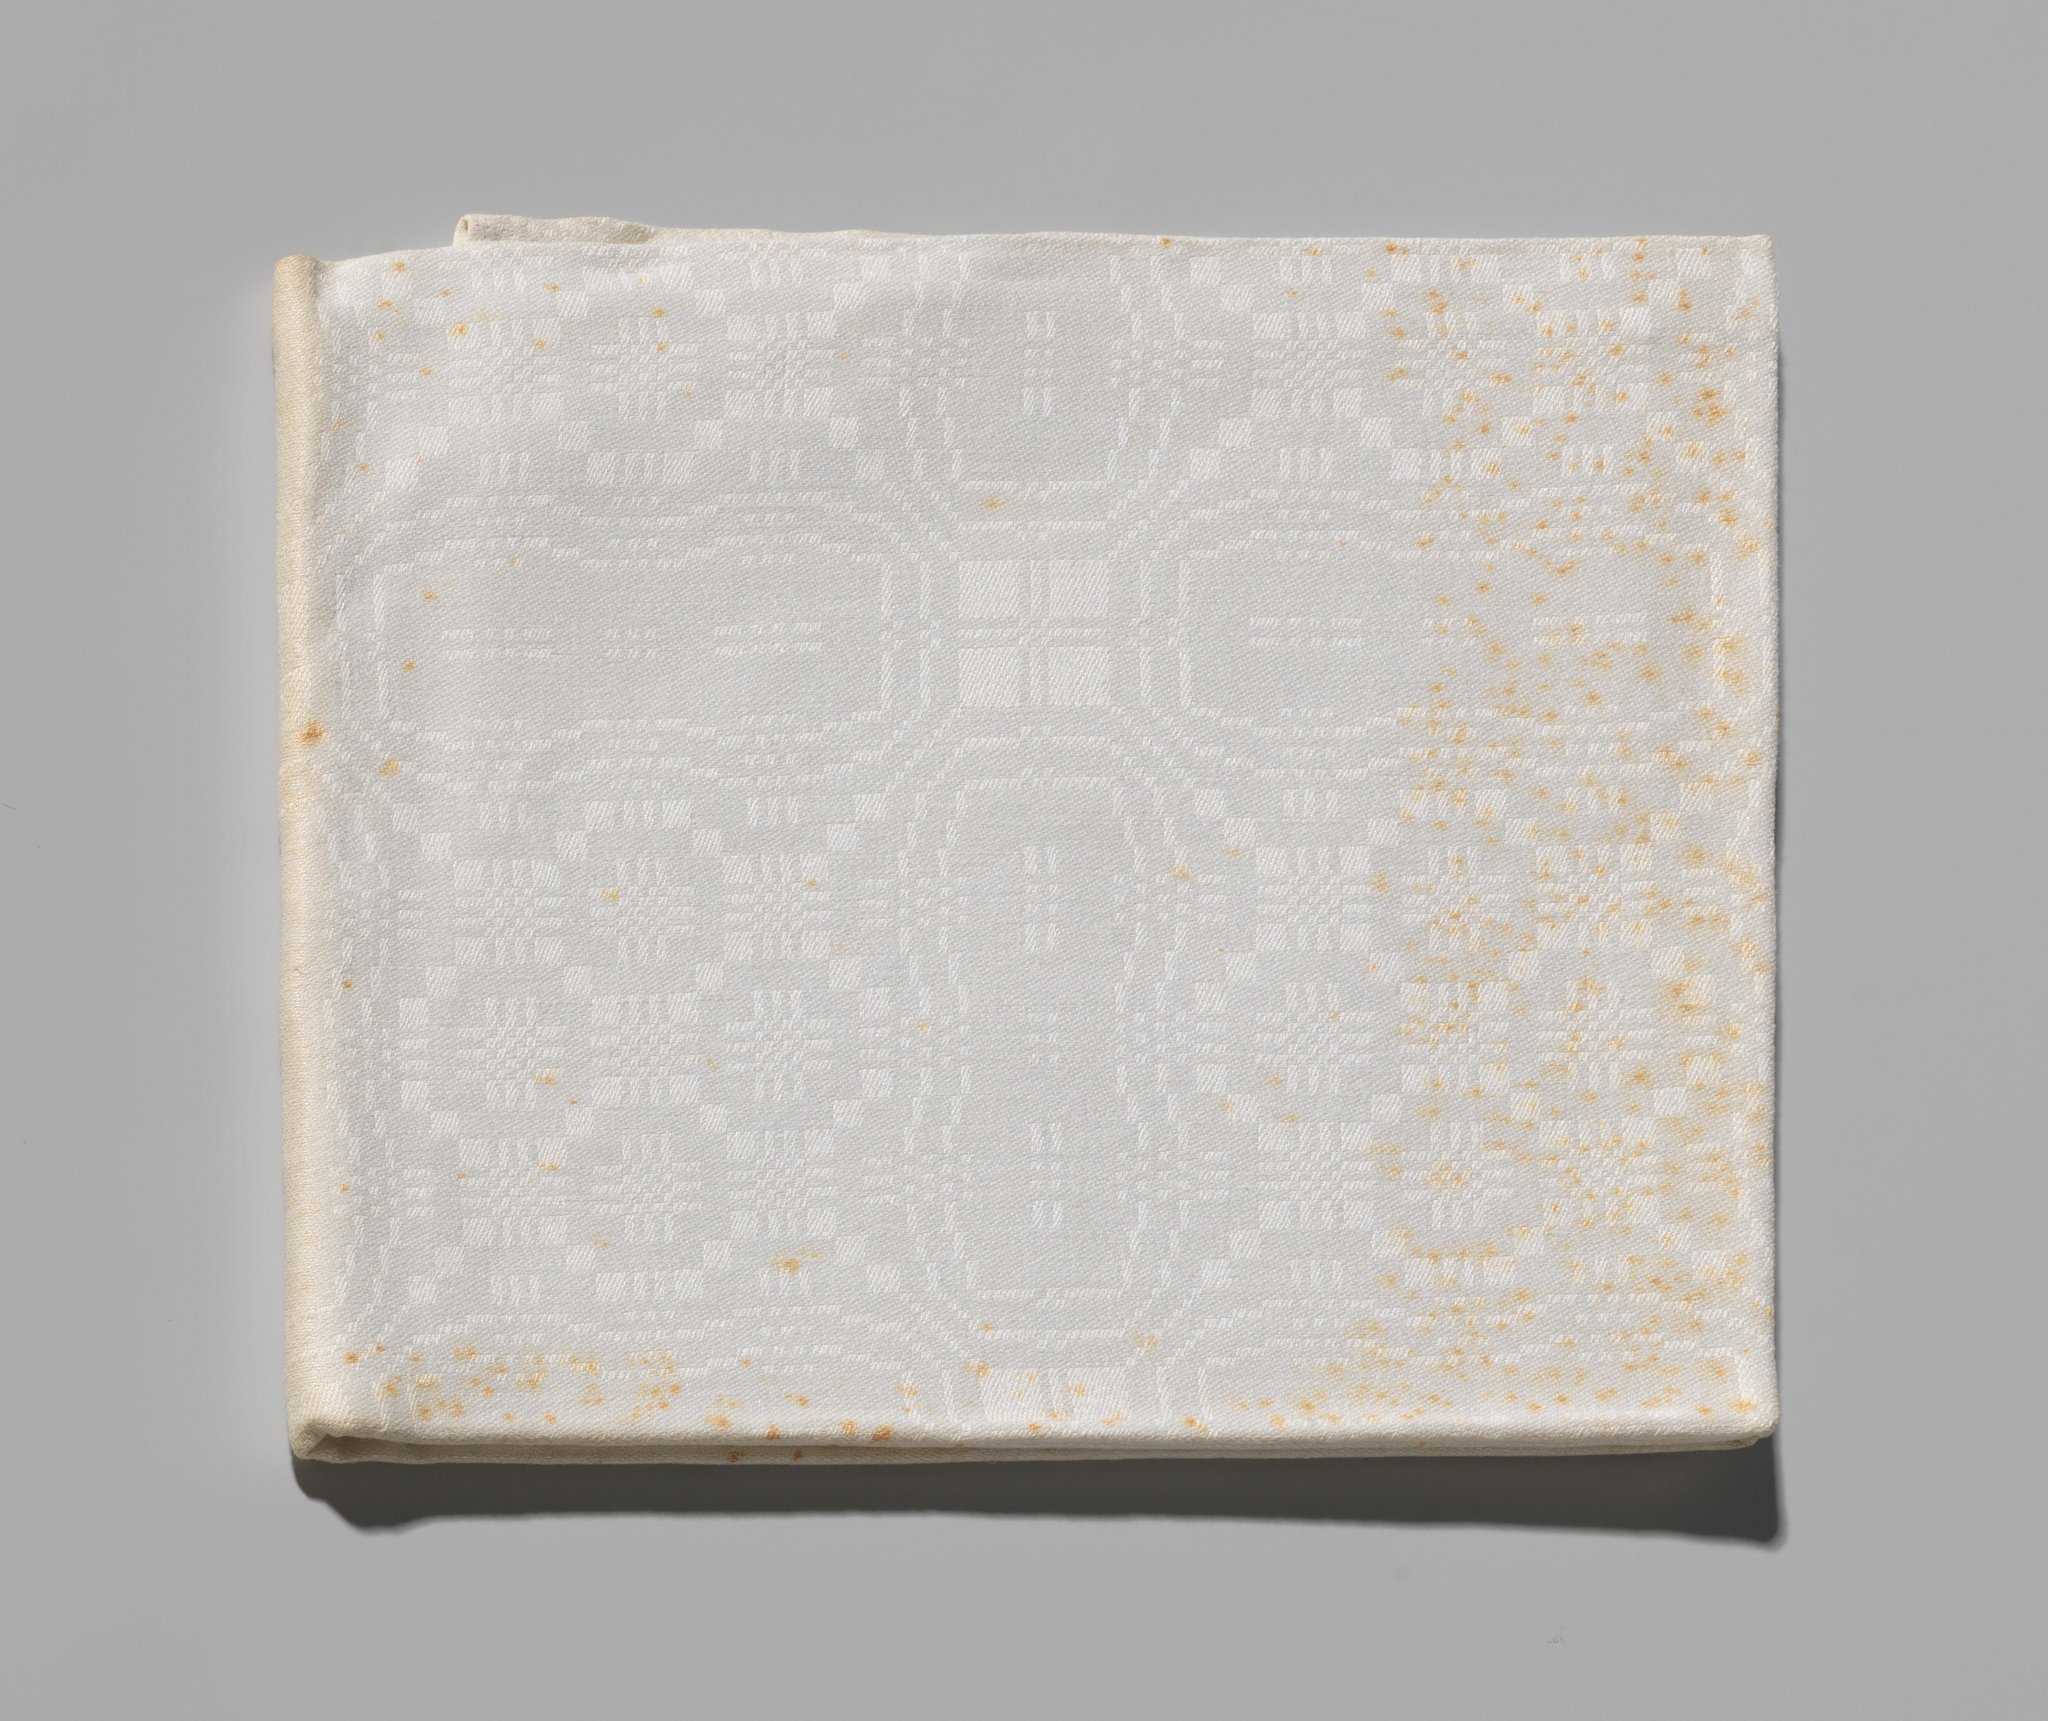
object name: napkin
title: Pellen. Merk geborduurd in de hoek: PP 12.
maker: Anonymous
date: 1800-1900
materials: linen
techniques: weave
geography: netherlands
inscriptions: monogram: ‘PP 12’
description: Servet van linnen pellendamast met randen rondom en in een hoek de geborduurde letters PP 12. Het servet hoort bij vijf servetten (BK-1980-161-A t/m BK-1980-161-F) en een tafellaken (BK-1980-160).